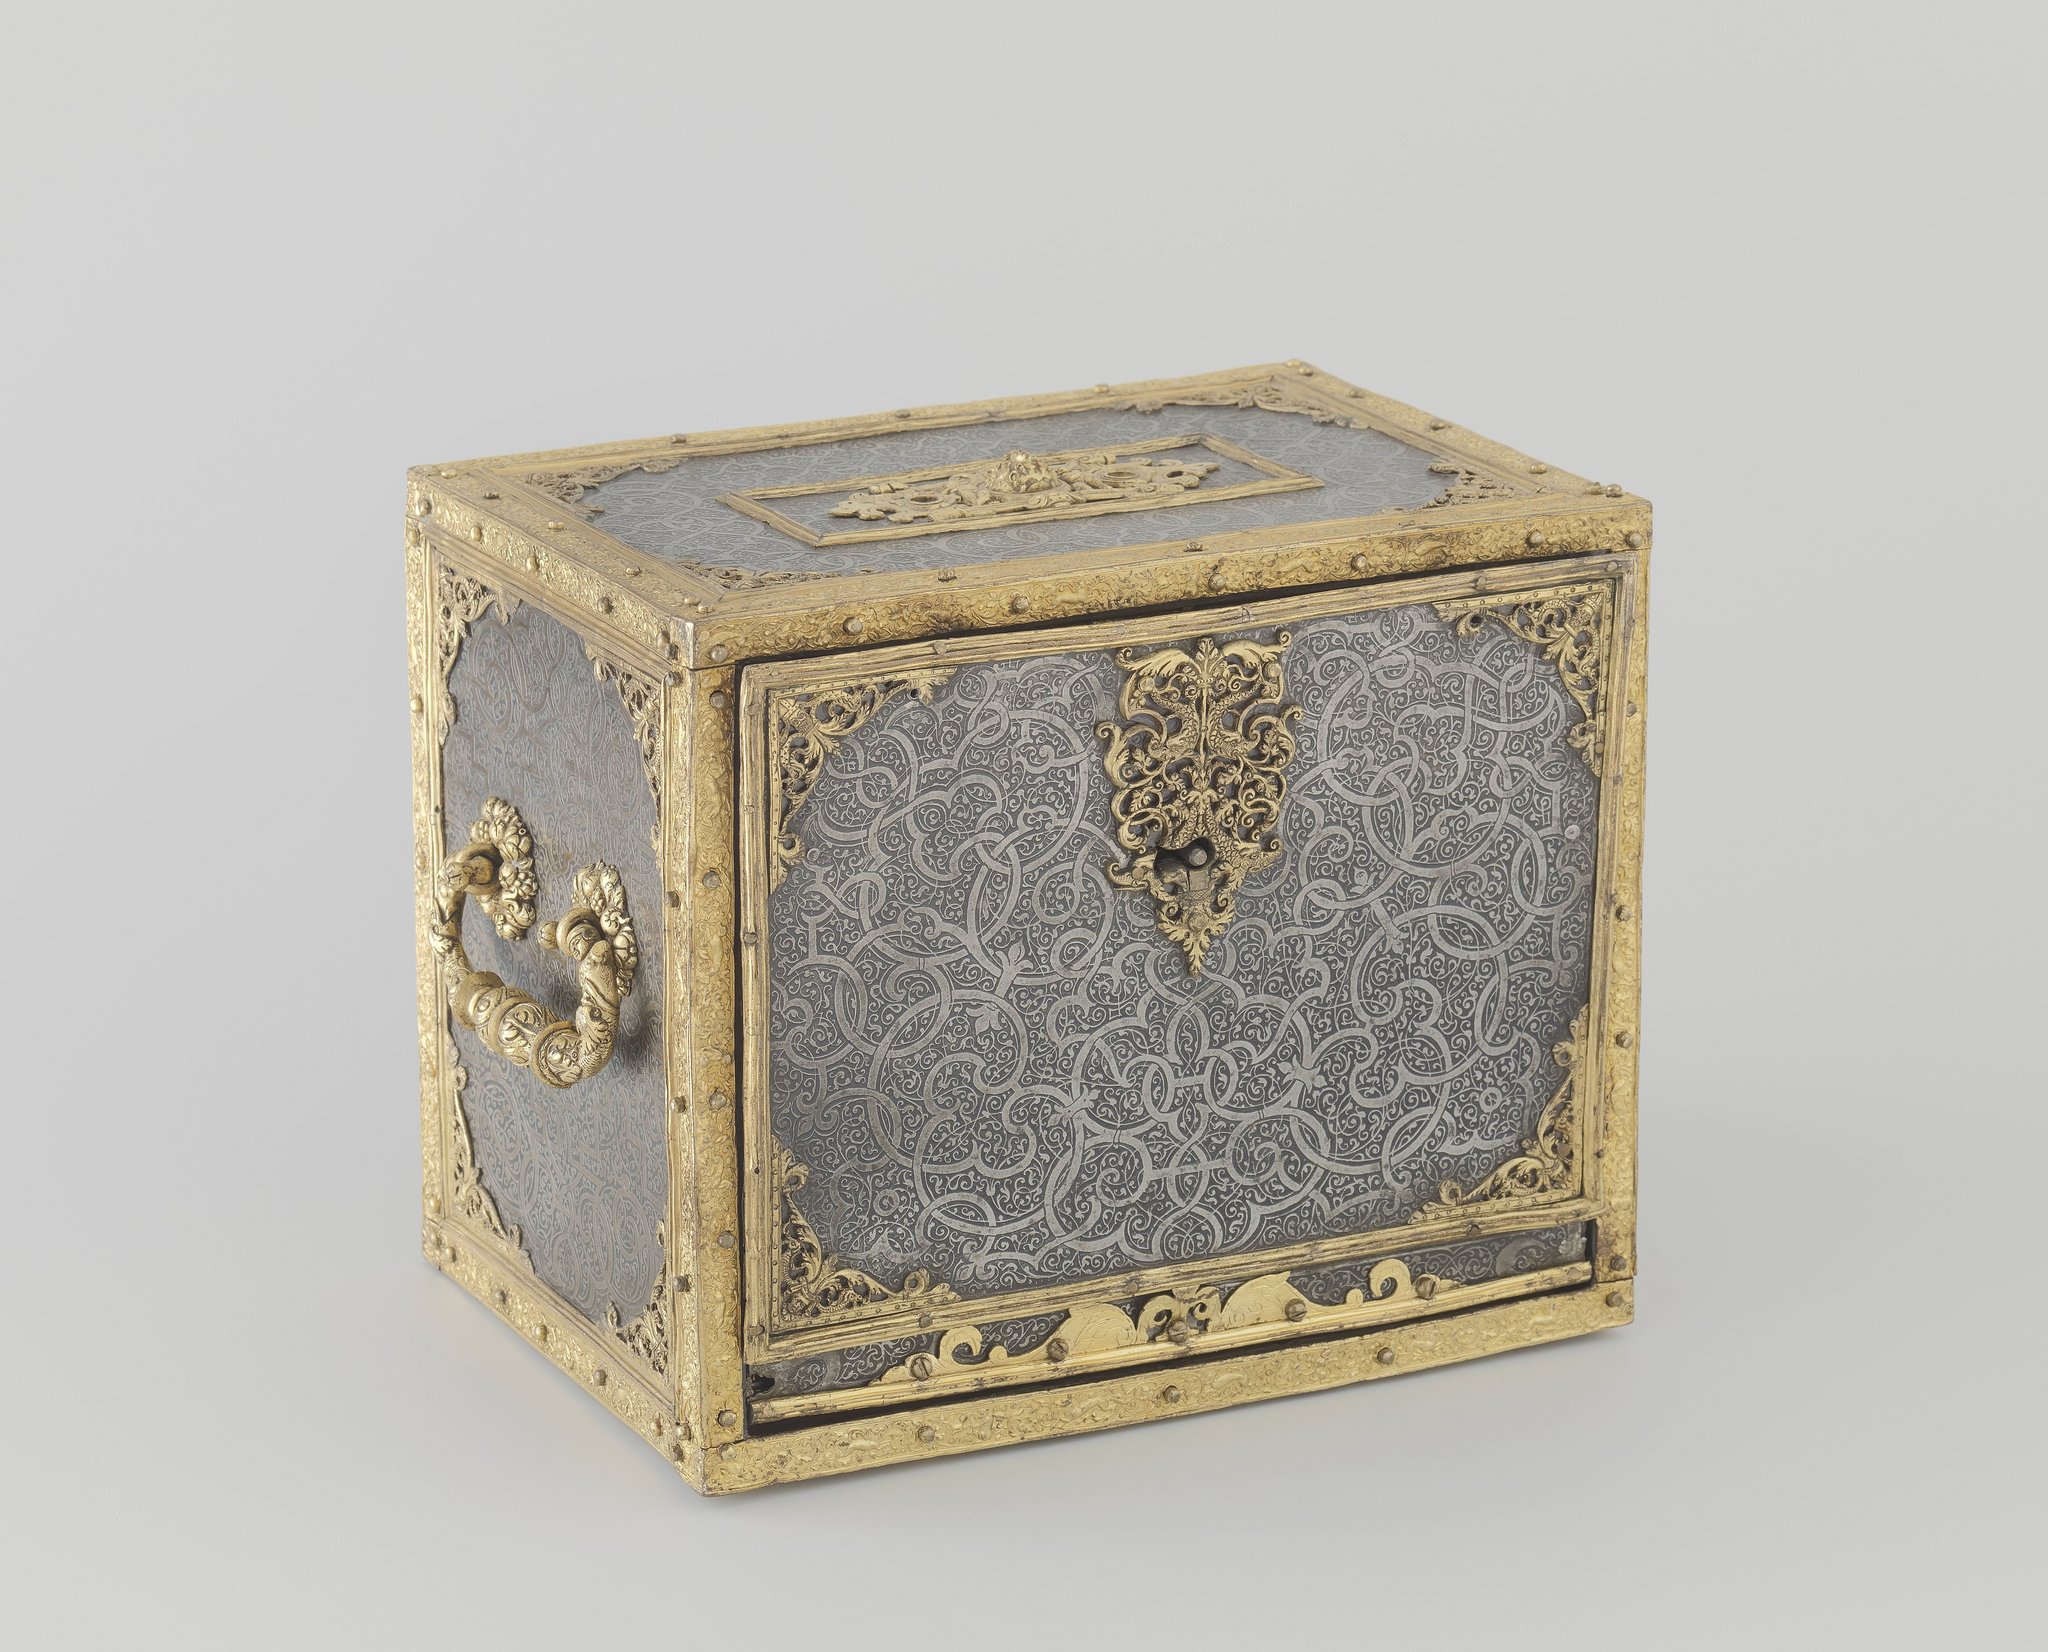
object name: jewelry box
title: Casket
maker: Anonymous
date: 1560-1600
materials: wood, copper, steel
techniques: engraving, etching, gilding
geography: augsburg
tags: justice, 'justitia'; 'giustitia divina' (ripa) ~ one of the four cardinal virtues, scrollwork, strapwork ~ ornament, 'geometria' (~ quadrivium); 'geometria' (ripa)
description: This casket exudes an air of luxury in every way. Its sides are faced with steel plates ornamented with a pattern of strapwork and foliage scrolls. The plates are set within finely worked gilt bronze mounts. The front opens, revealing nine little drawers of various sizes that were probably meant to hold jewellery or other small precious objects.